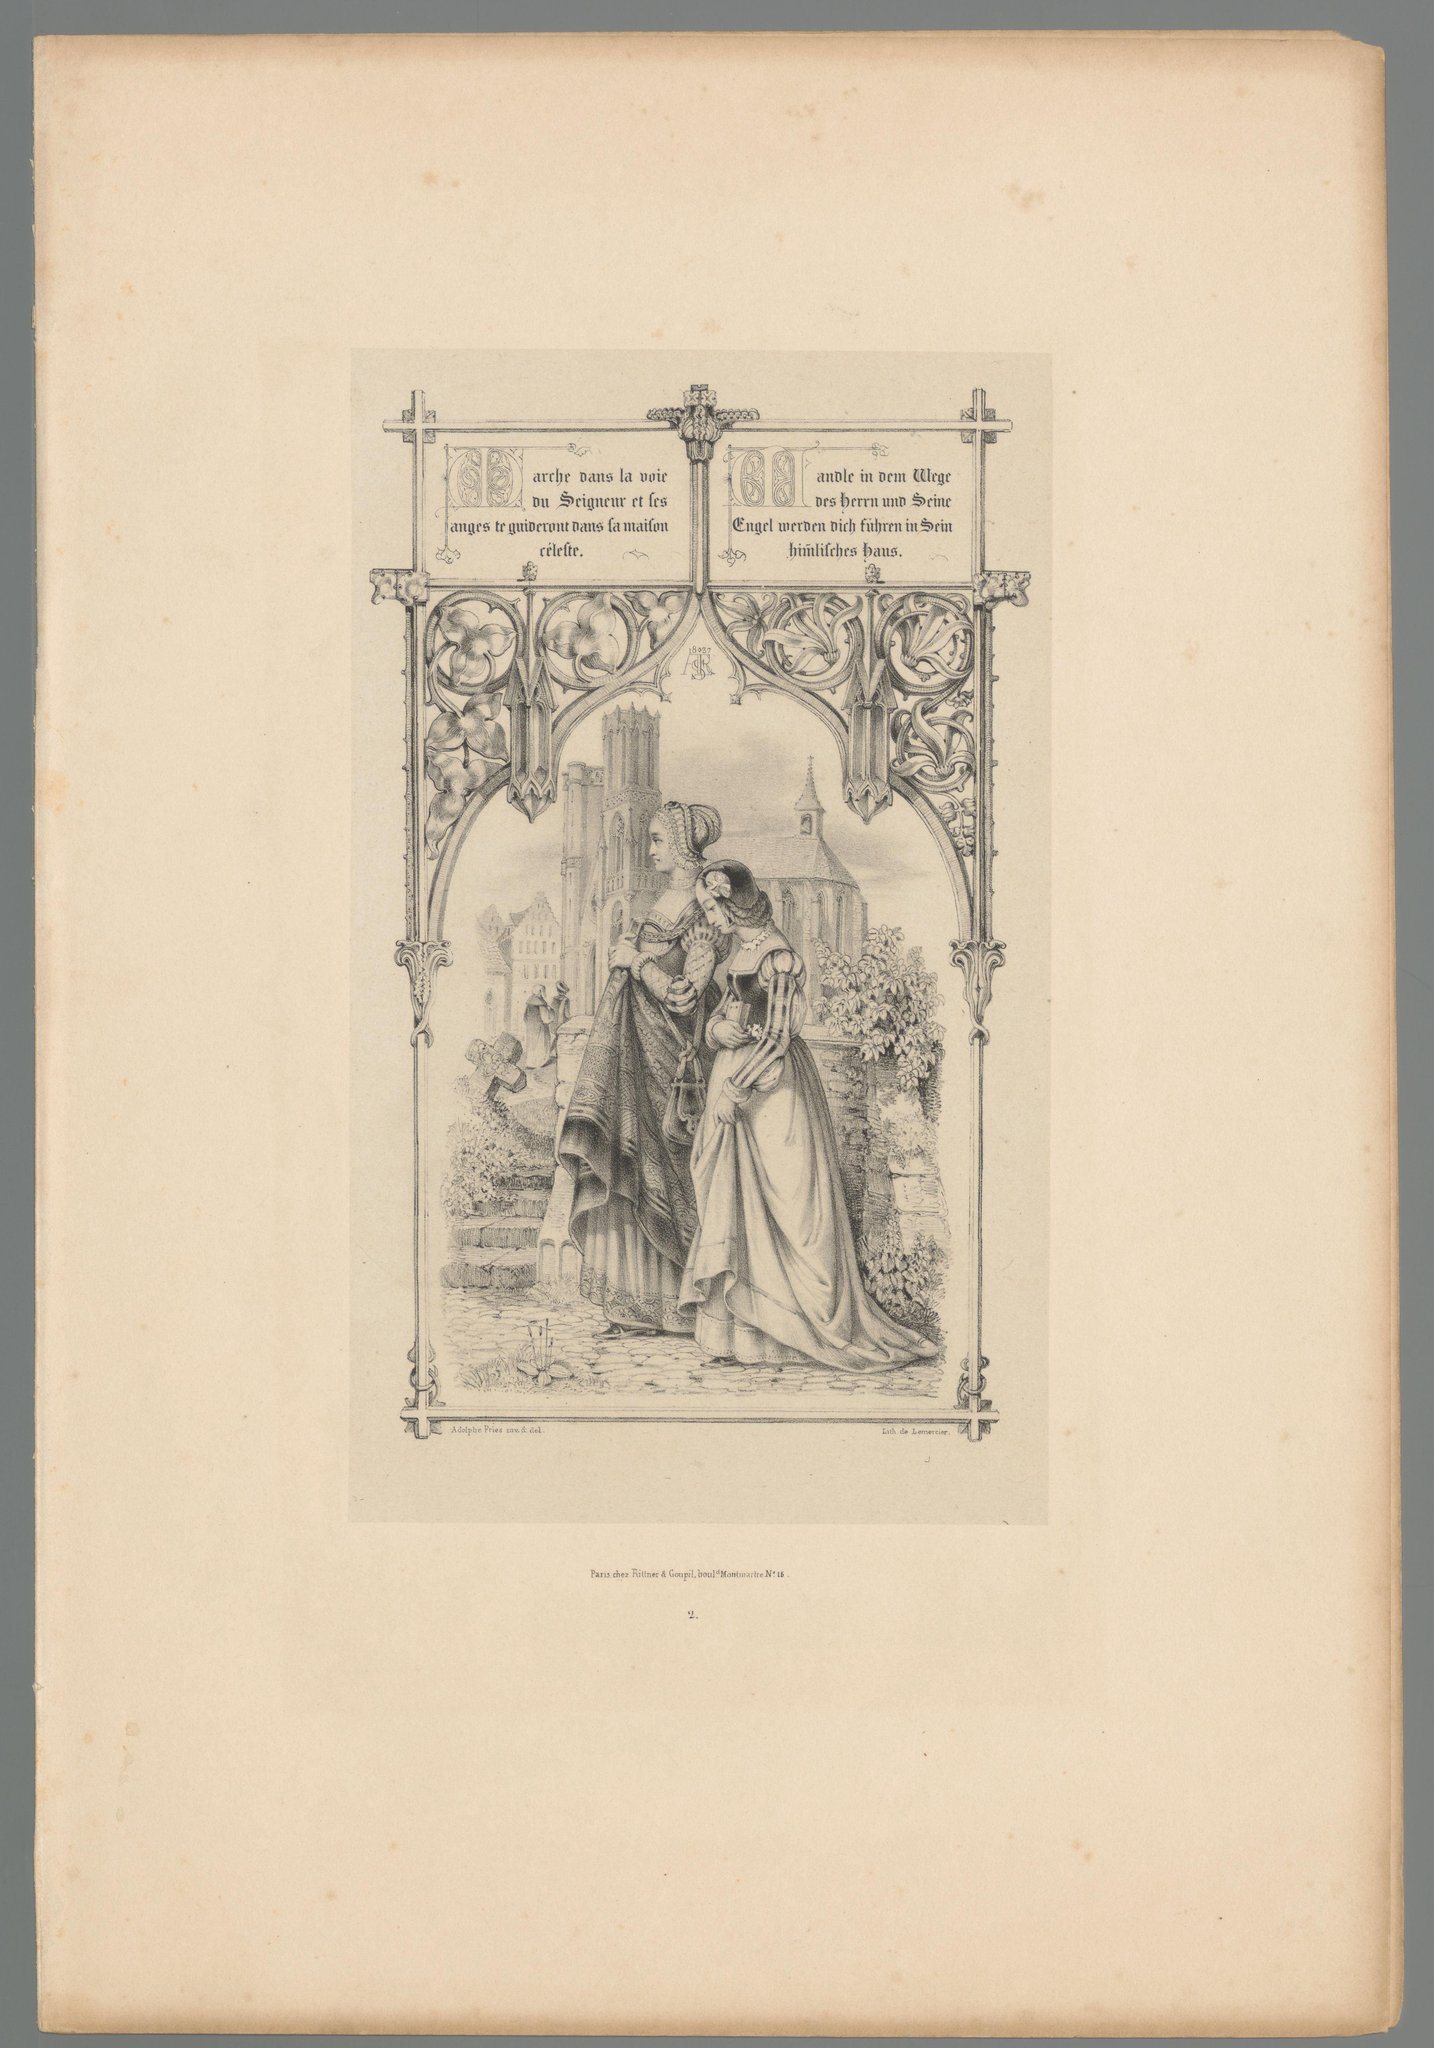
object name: print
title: Woorden van de ziel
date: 1837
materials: paper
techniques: lithograph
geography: paris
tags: church (exterior), adult woman (+ two persons), ornament derived from architectural details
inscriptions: collector's mark: Lugt 2228